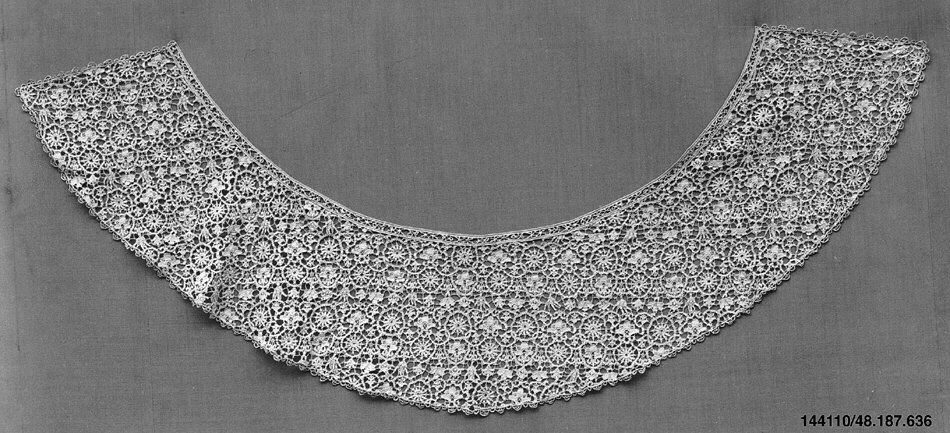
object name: bertha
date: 1567-1633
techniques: lace